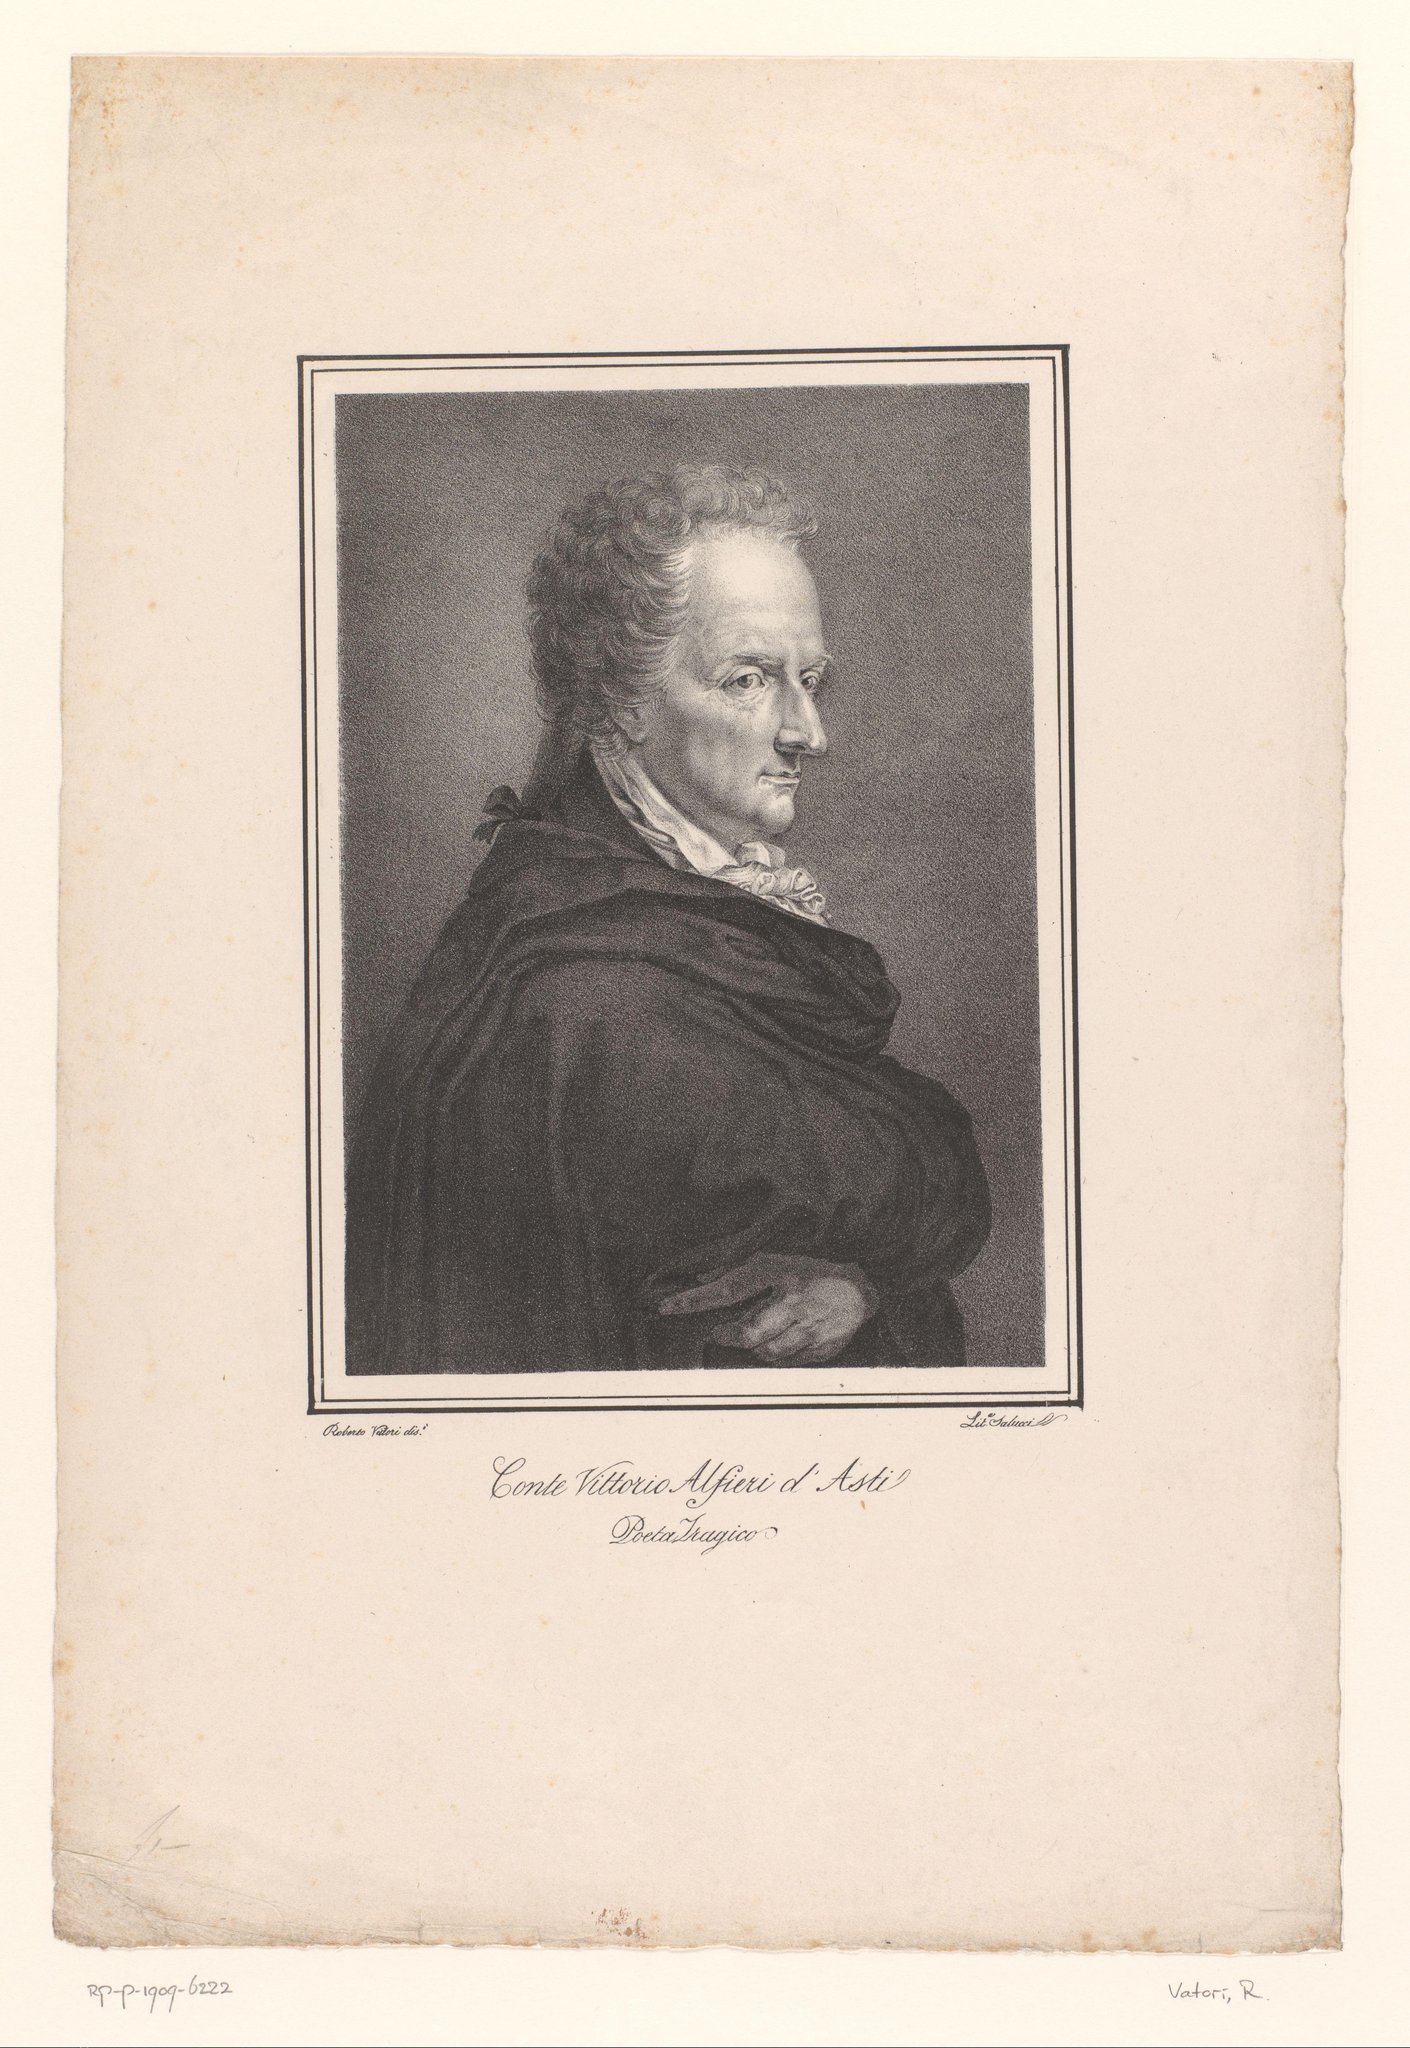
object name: print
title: Portret van schrijver, dichter en acteur Vittorio Alfieri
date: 1800-1899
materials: paper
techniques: lithograph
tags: historical persons, portrait of a writer, portrait of actor, actress, writer, poet, author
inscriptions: collector's mark: Lugt 2228